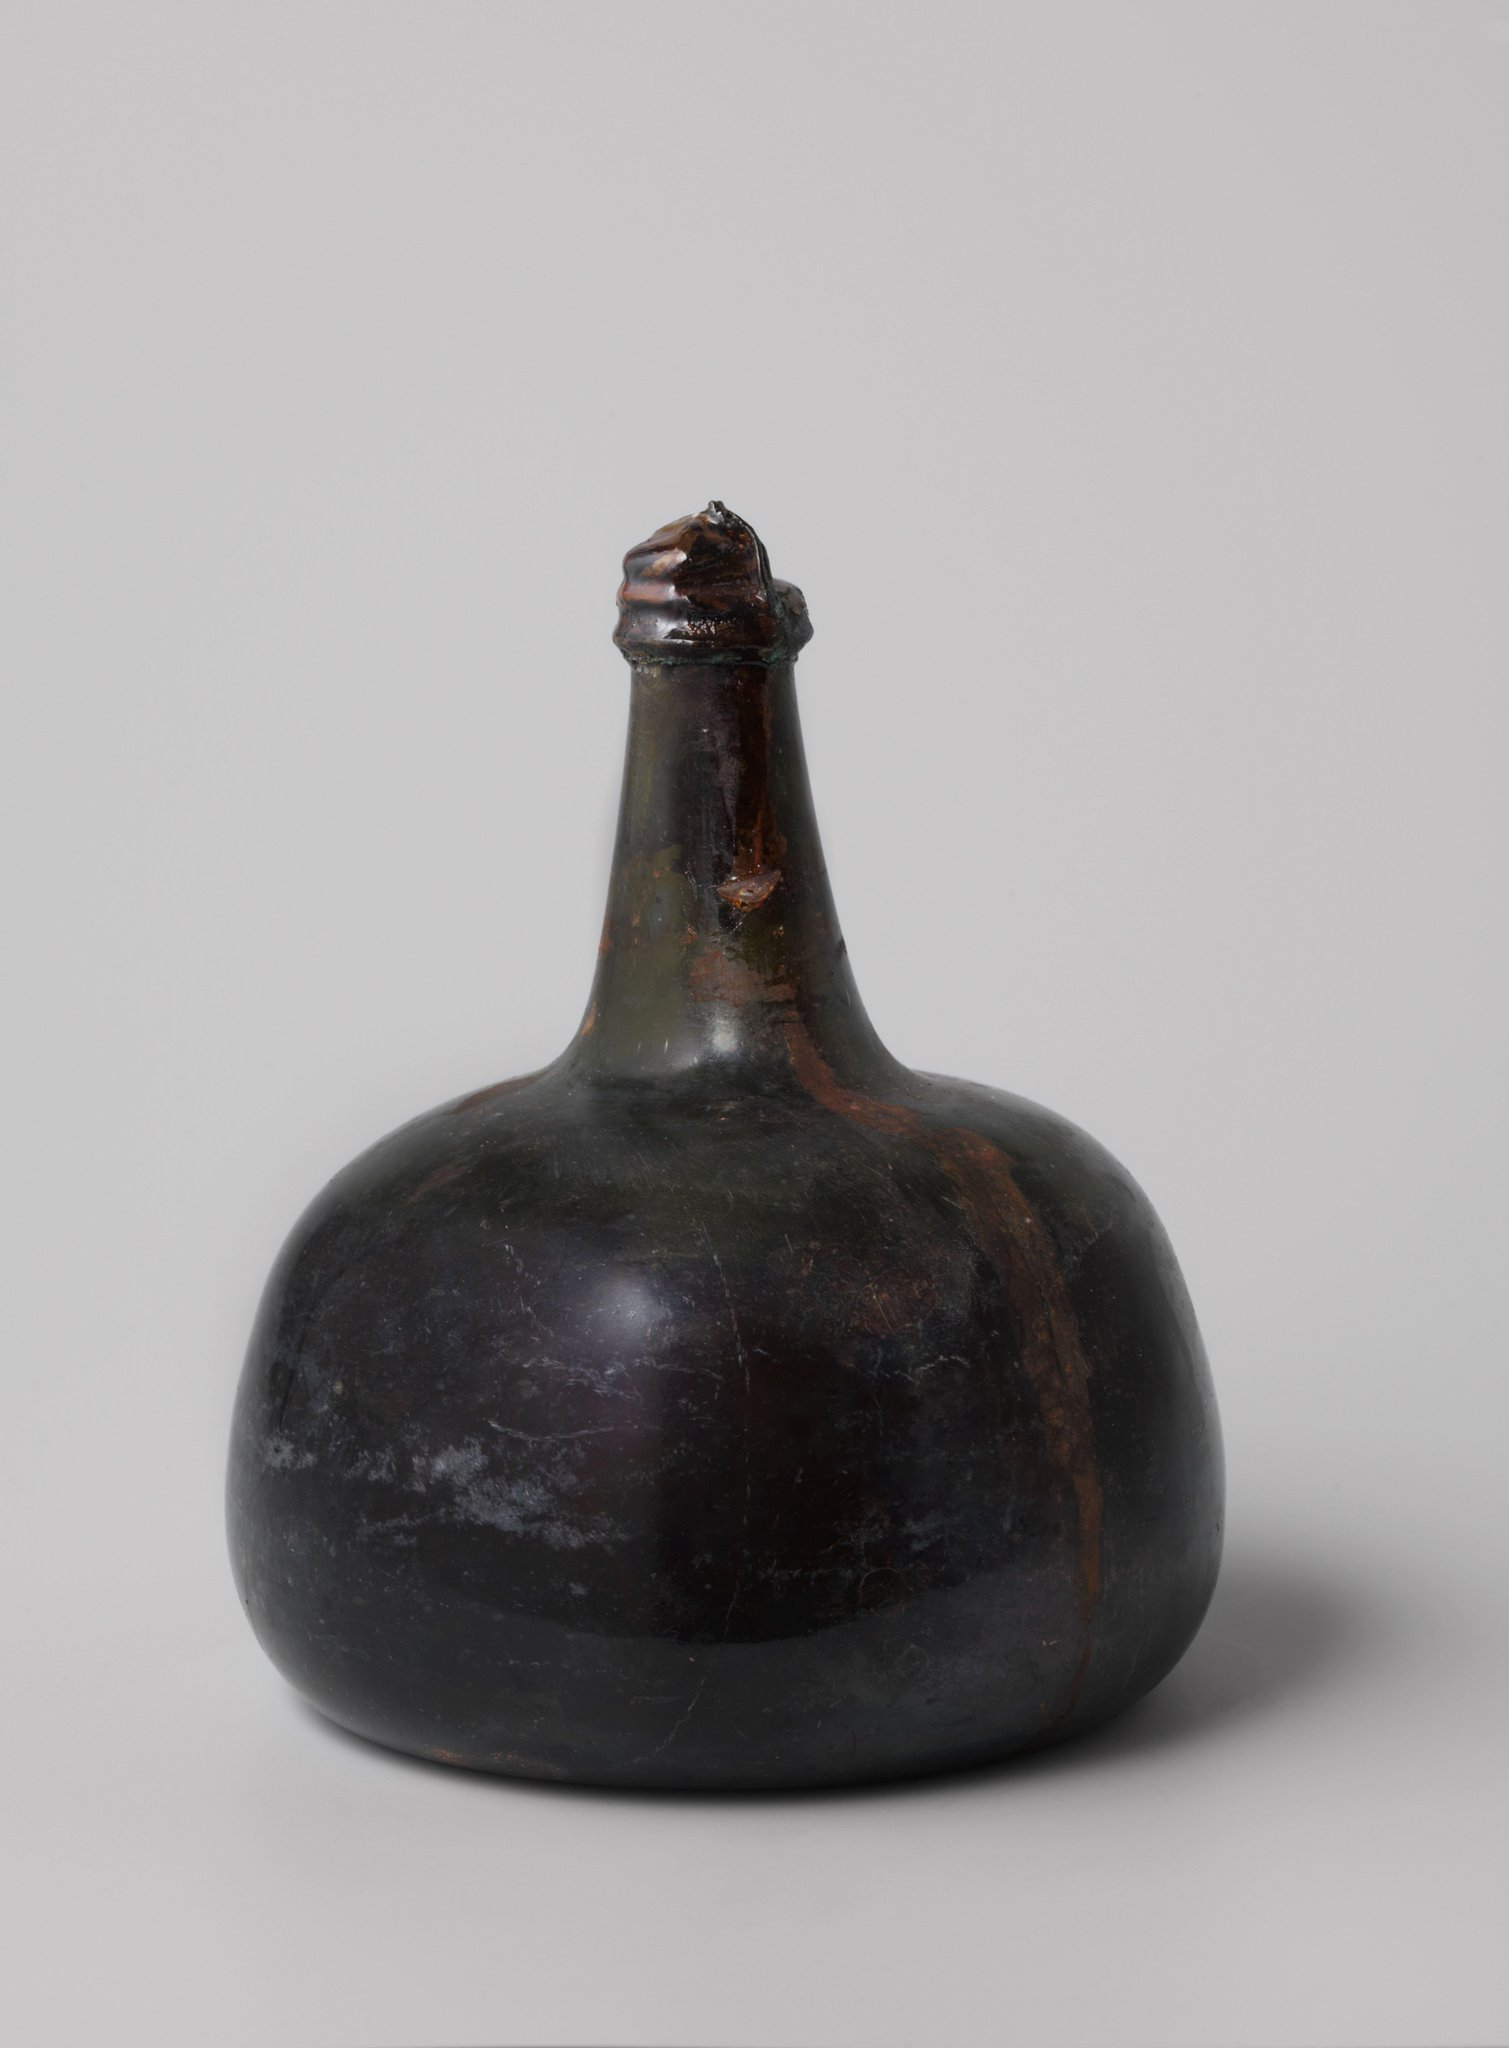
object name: wine bottle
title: Wijnfles met wijn uit het wrak van de Oost-Indiëvaarder 't Vliegend Hart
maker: Anonymous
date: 1700-1735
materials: cork, glass, lacquer, liquid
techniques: manufacturing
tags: 't vliegend hart (schip), verenigde oostindische compagnie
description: De gaveuivormige groene wijnfles is geheel gevuld met wijn. De fles is dichtgemaakt met een kurk, koperdraad en lak.